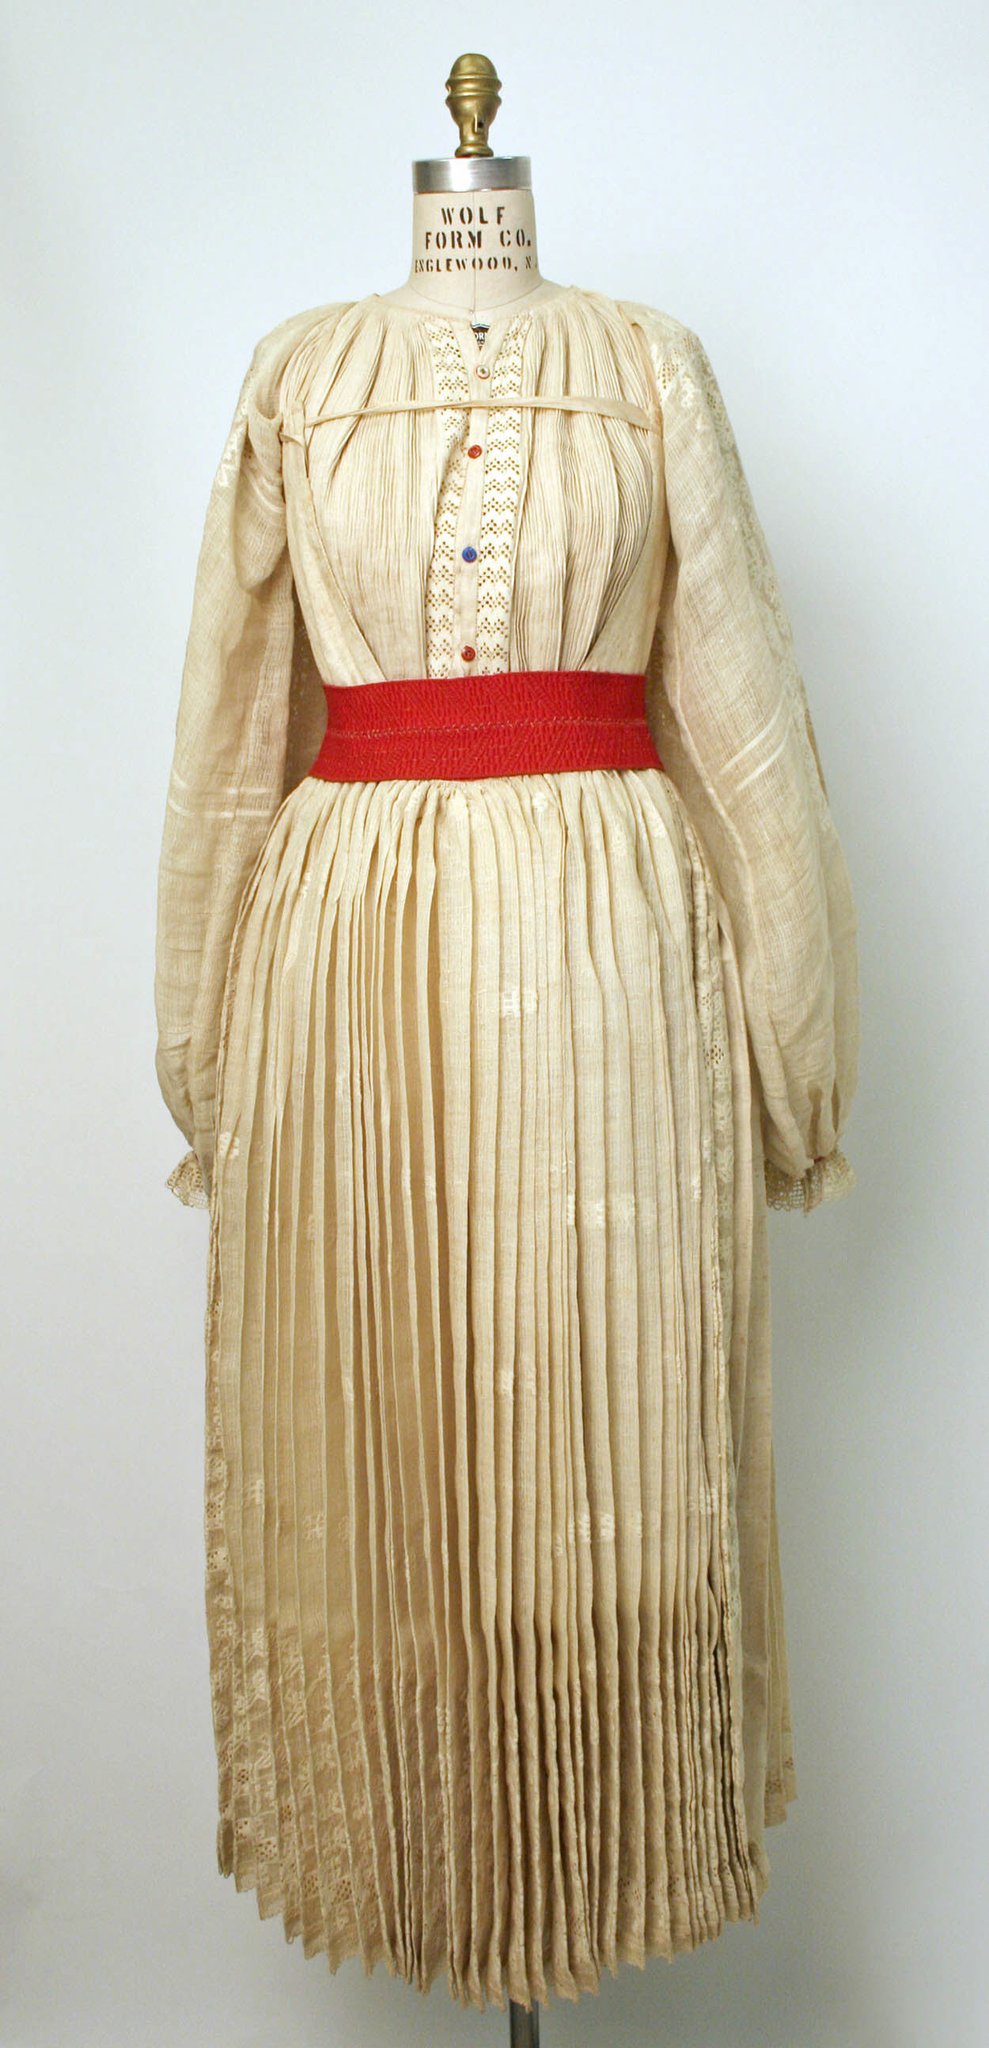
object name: ensemble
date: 1801-1900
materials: leather, linen, metal, silk, wool